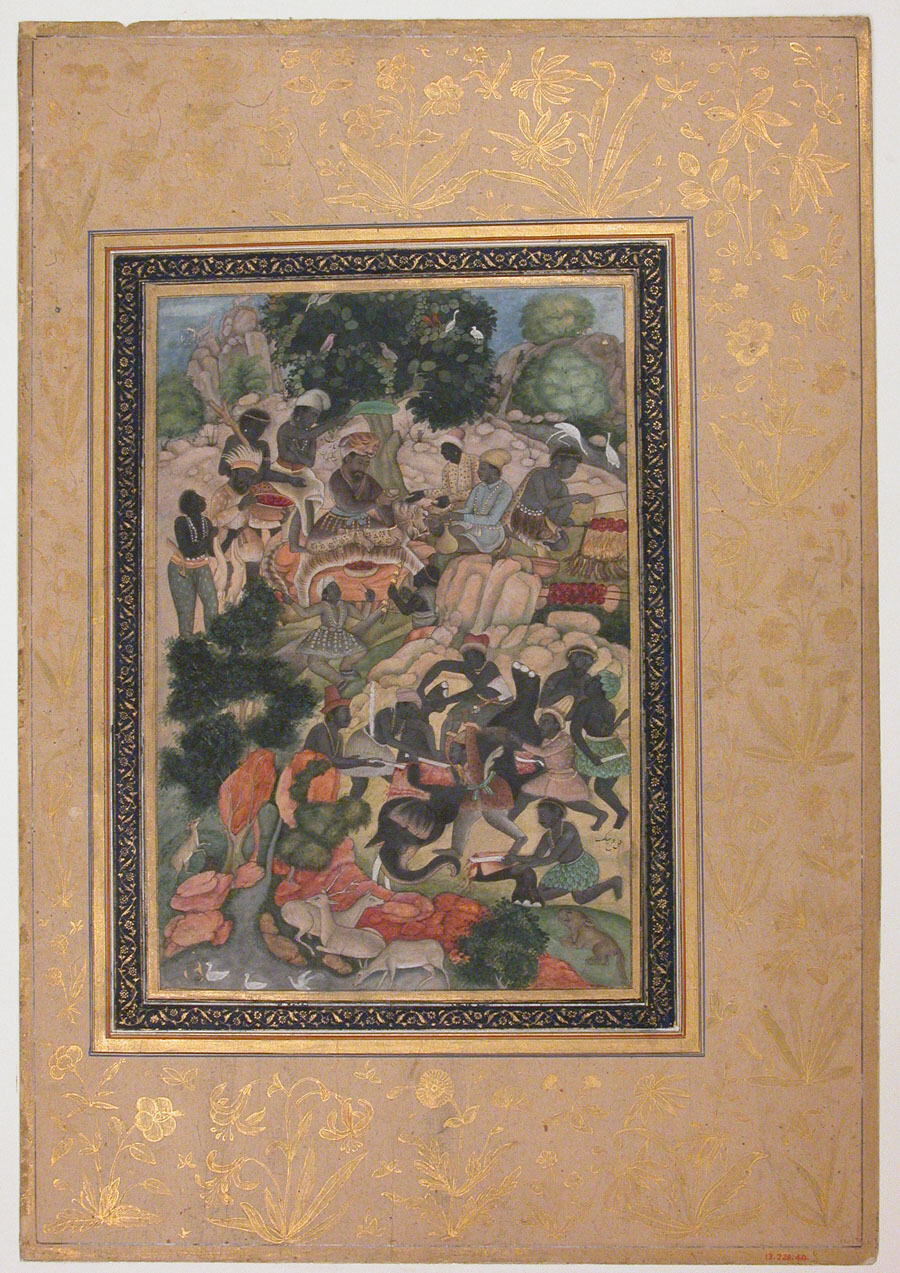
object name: illustrated album leaf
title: Servants Cutting up an Elephant in the Presence of their Ruler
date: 1801-1900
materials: gold, paper, watercolor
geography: india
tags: men,deer,elephants,servants